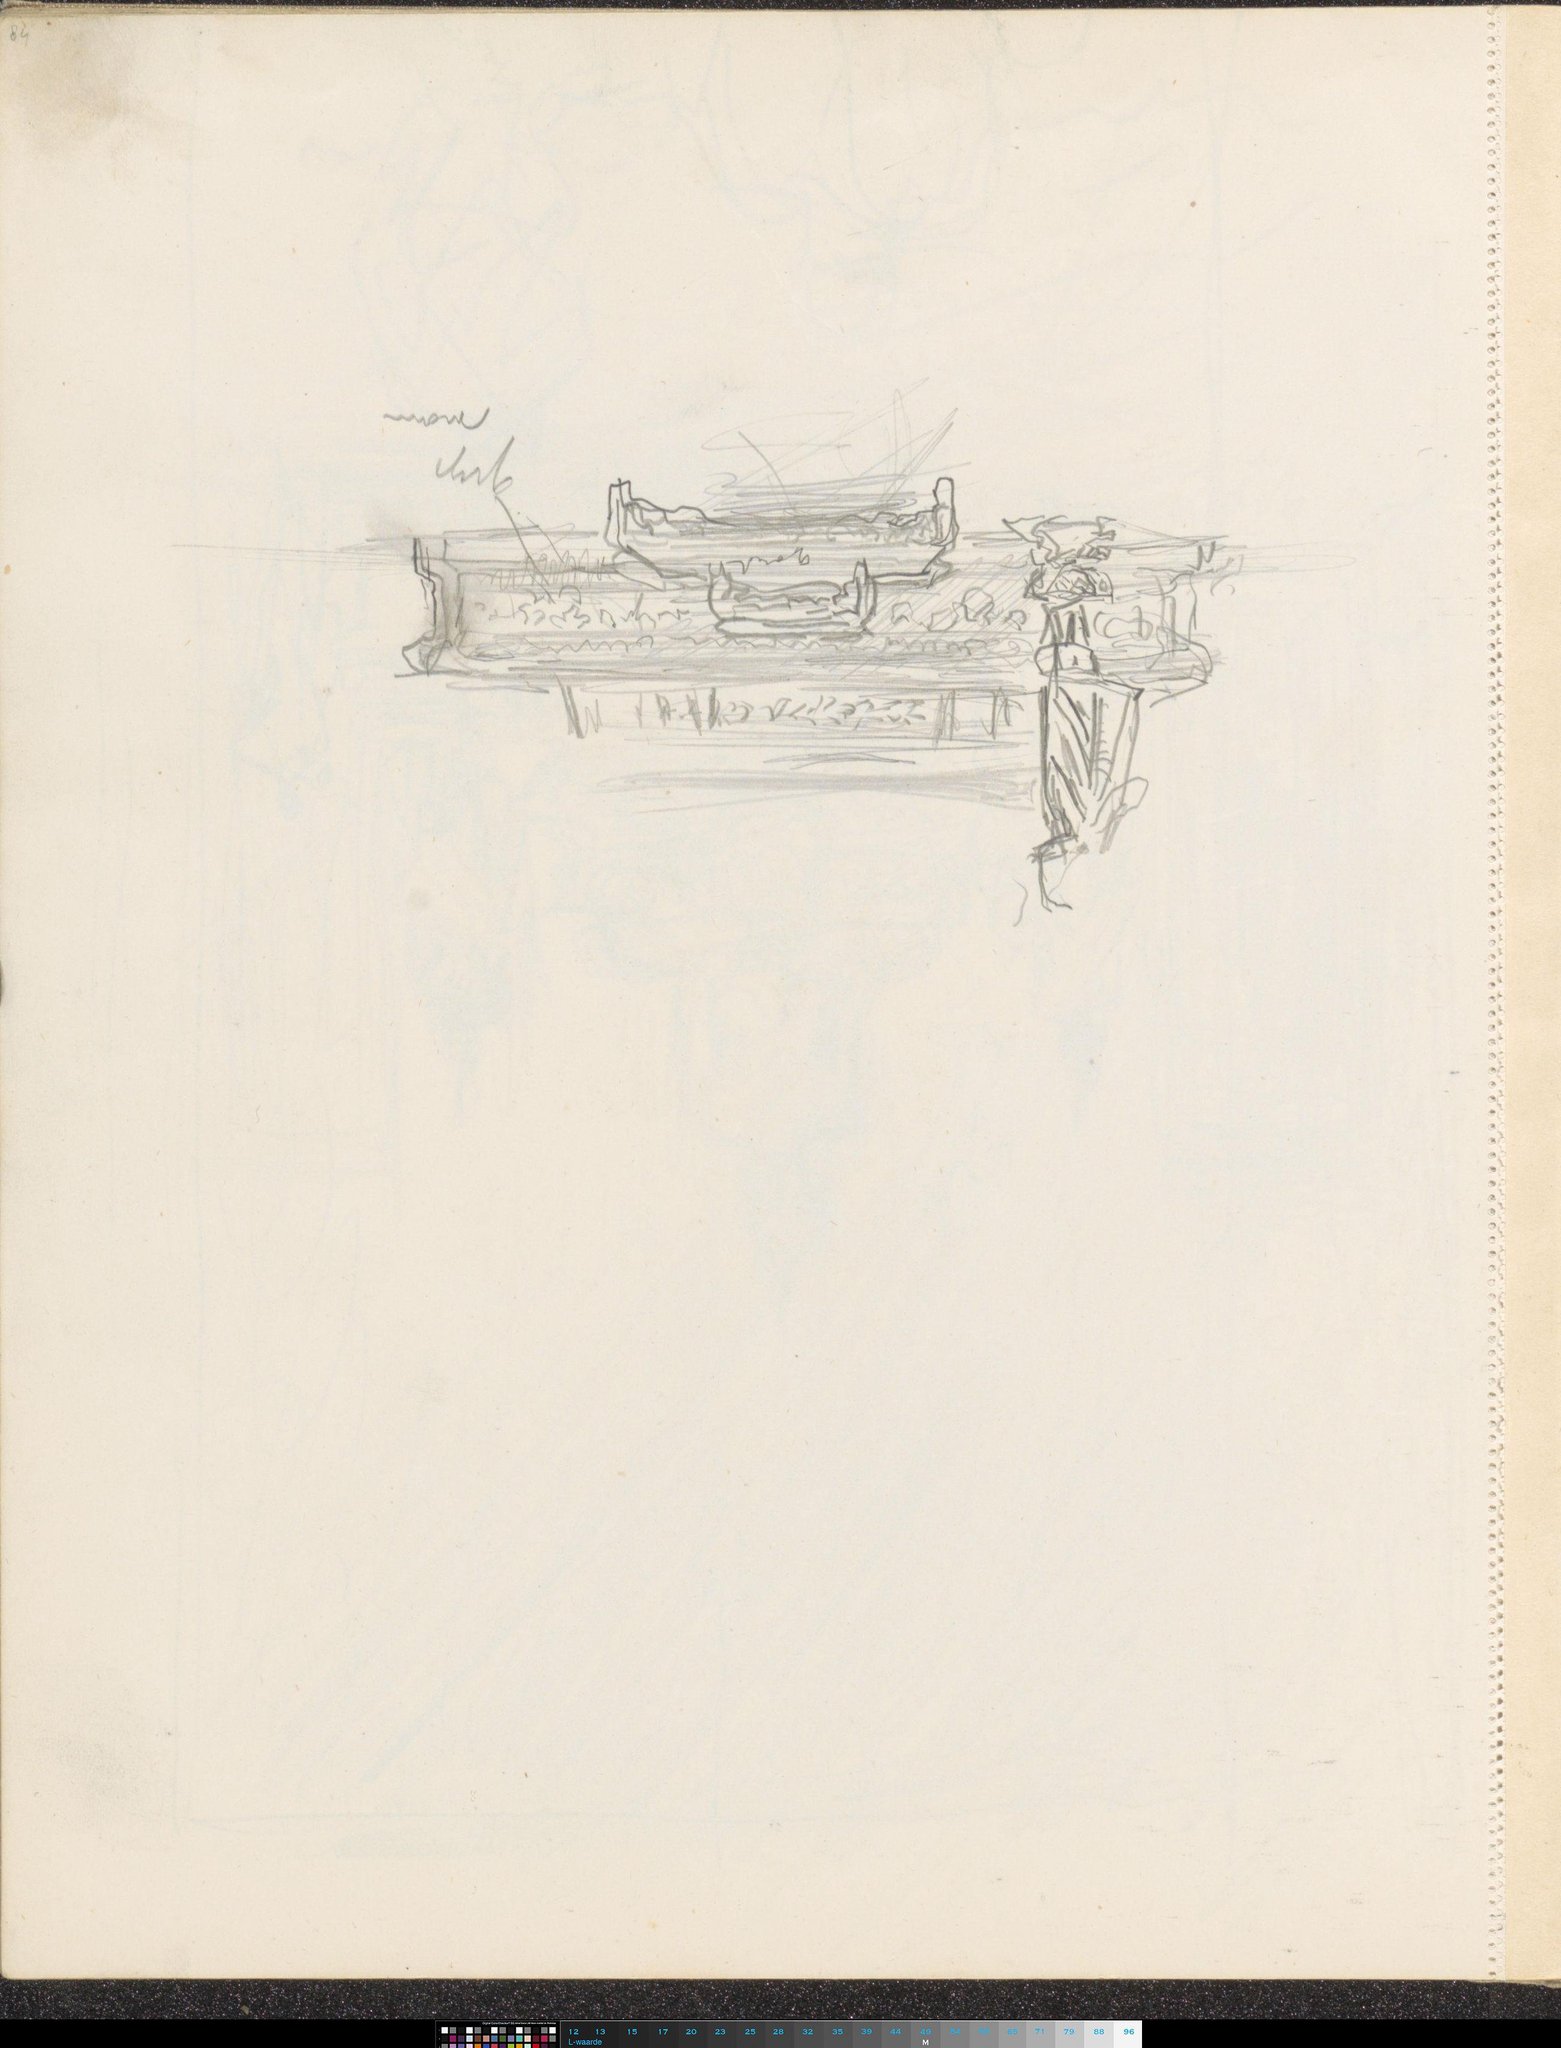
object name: sketchbook leaf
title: Altaar met een knielbank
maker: marius bauer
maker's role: draughtsman, print maker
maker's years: 1867-1932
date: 1931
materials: paper, pencil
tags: statues, paintings, etc. ~ objects of worship (hinduism, buddhism, jainism)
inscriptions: kleurnotitie, handgeschreven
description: Pagina 84 uit een schetsboek met 48 bladen.